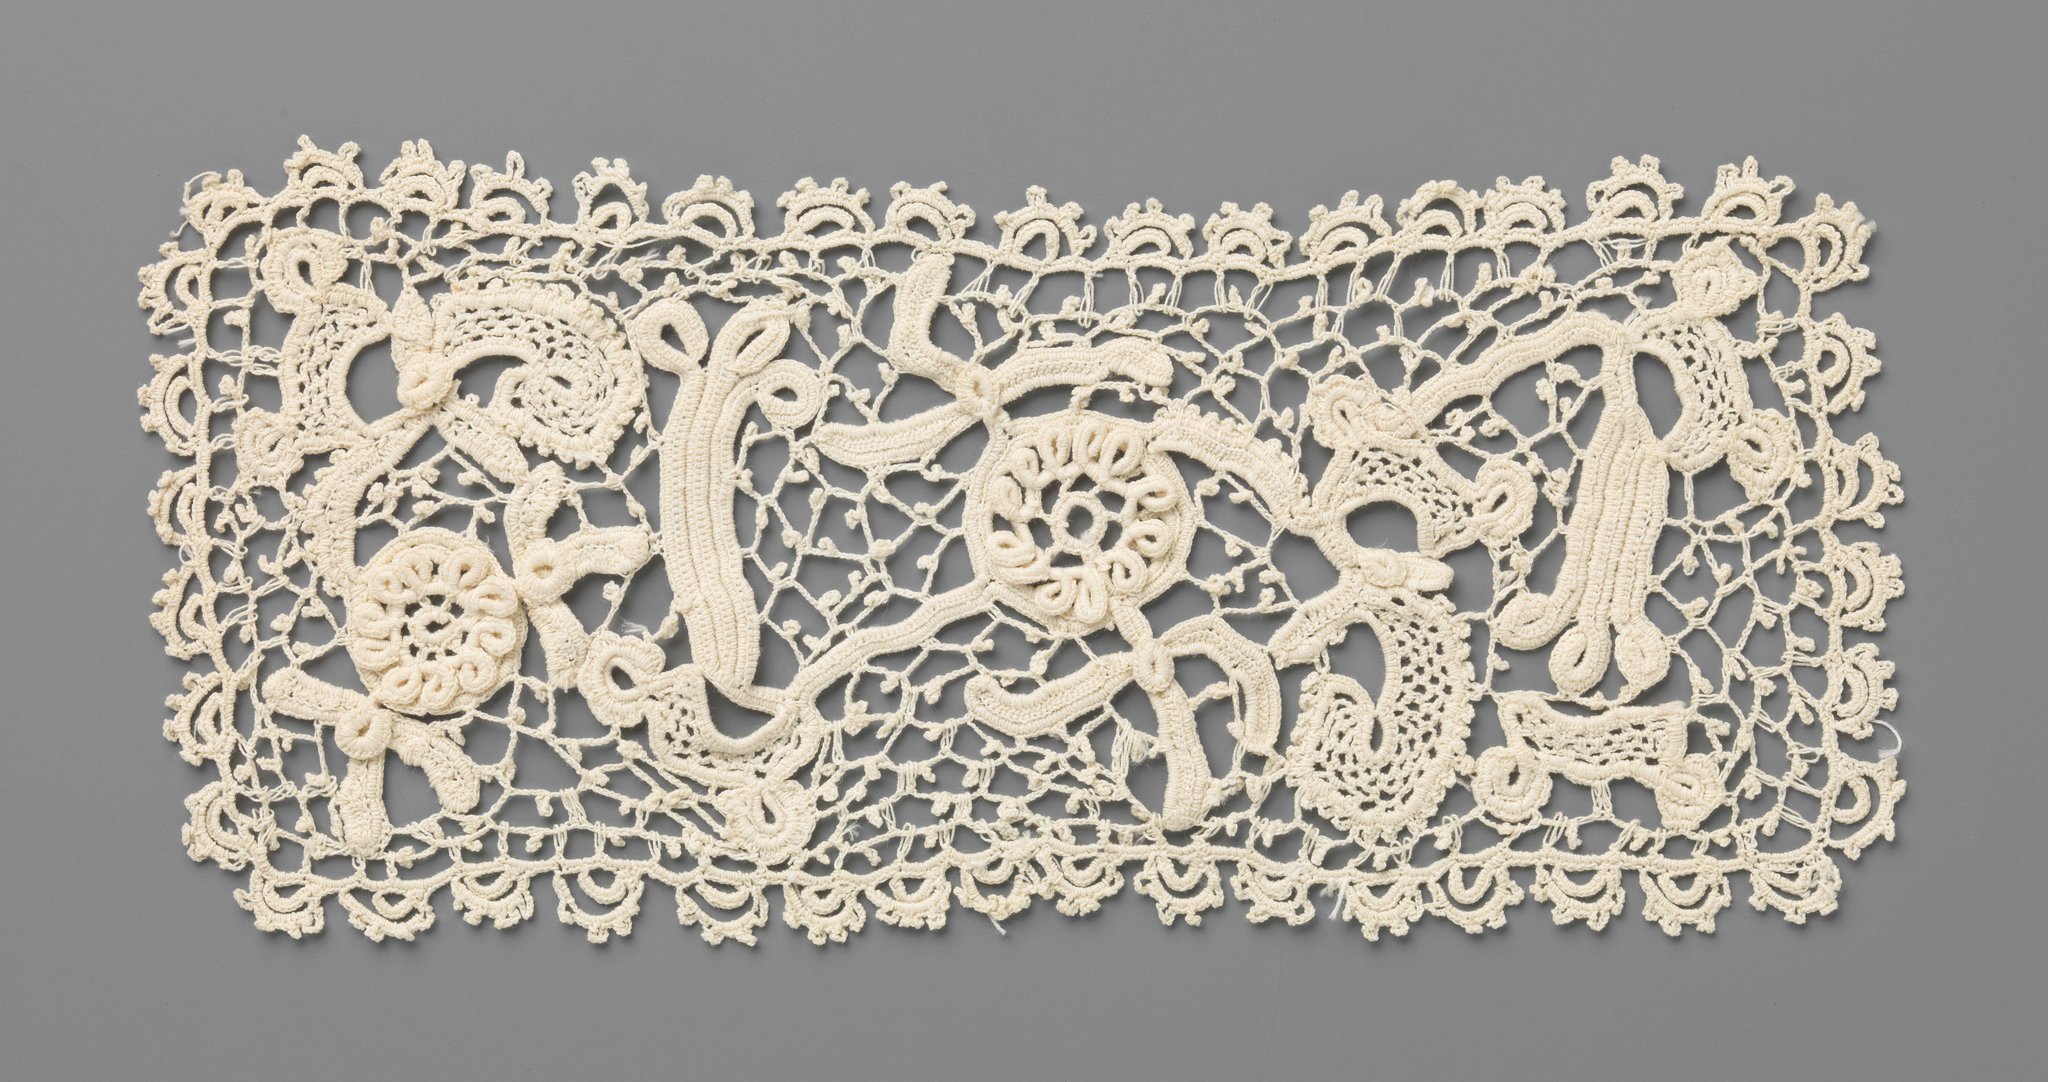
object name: cuff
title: Manchet van gehaakte kant met ronde bloemen en langwerpige kelkbloemen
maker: Anonymous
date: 1900-1910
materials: cotton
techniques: crocheted lace, irish crochet lace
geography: netherlands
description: Manchet van naturelkleurige Ierse gehaakte kant. Rechthoekig model. Patroon met twee ronde bloemen en twee langwerpige kelkbloemen. De manchet is rondom afgewerkt met een schulpenrand van dubbele boogjes, met picots aan de buitenste boogjes.